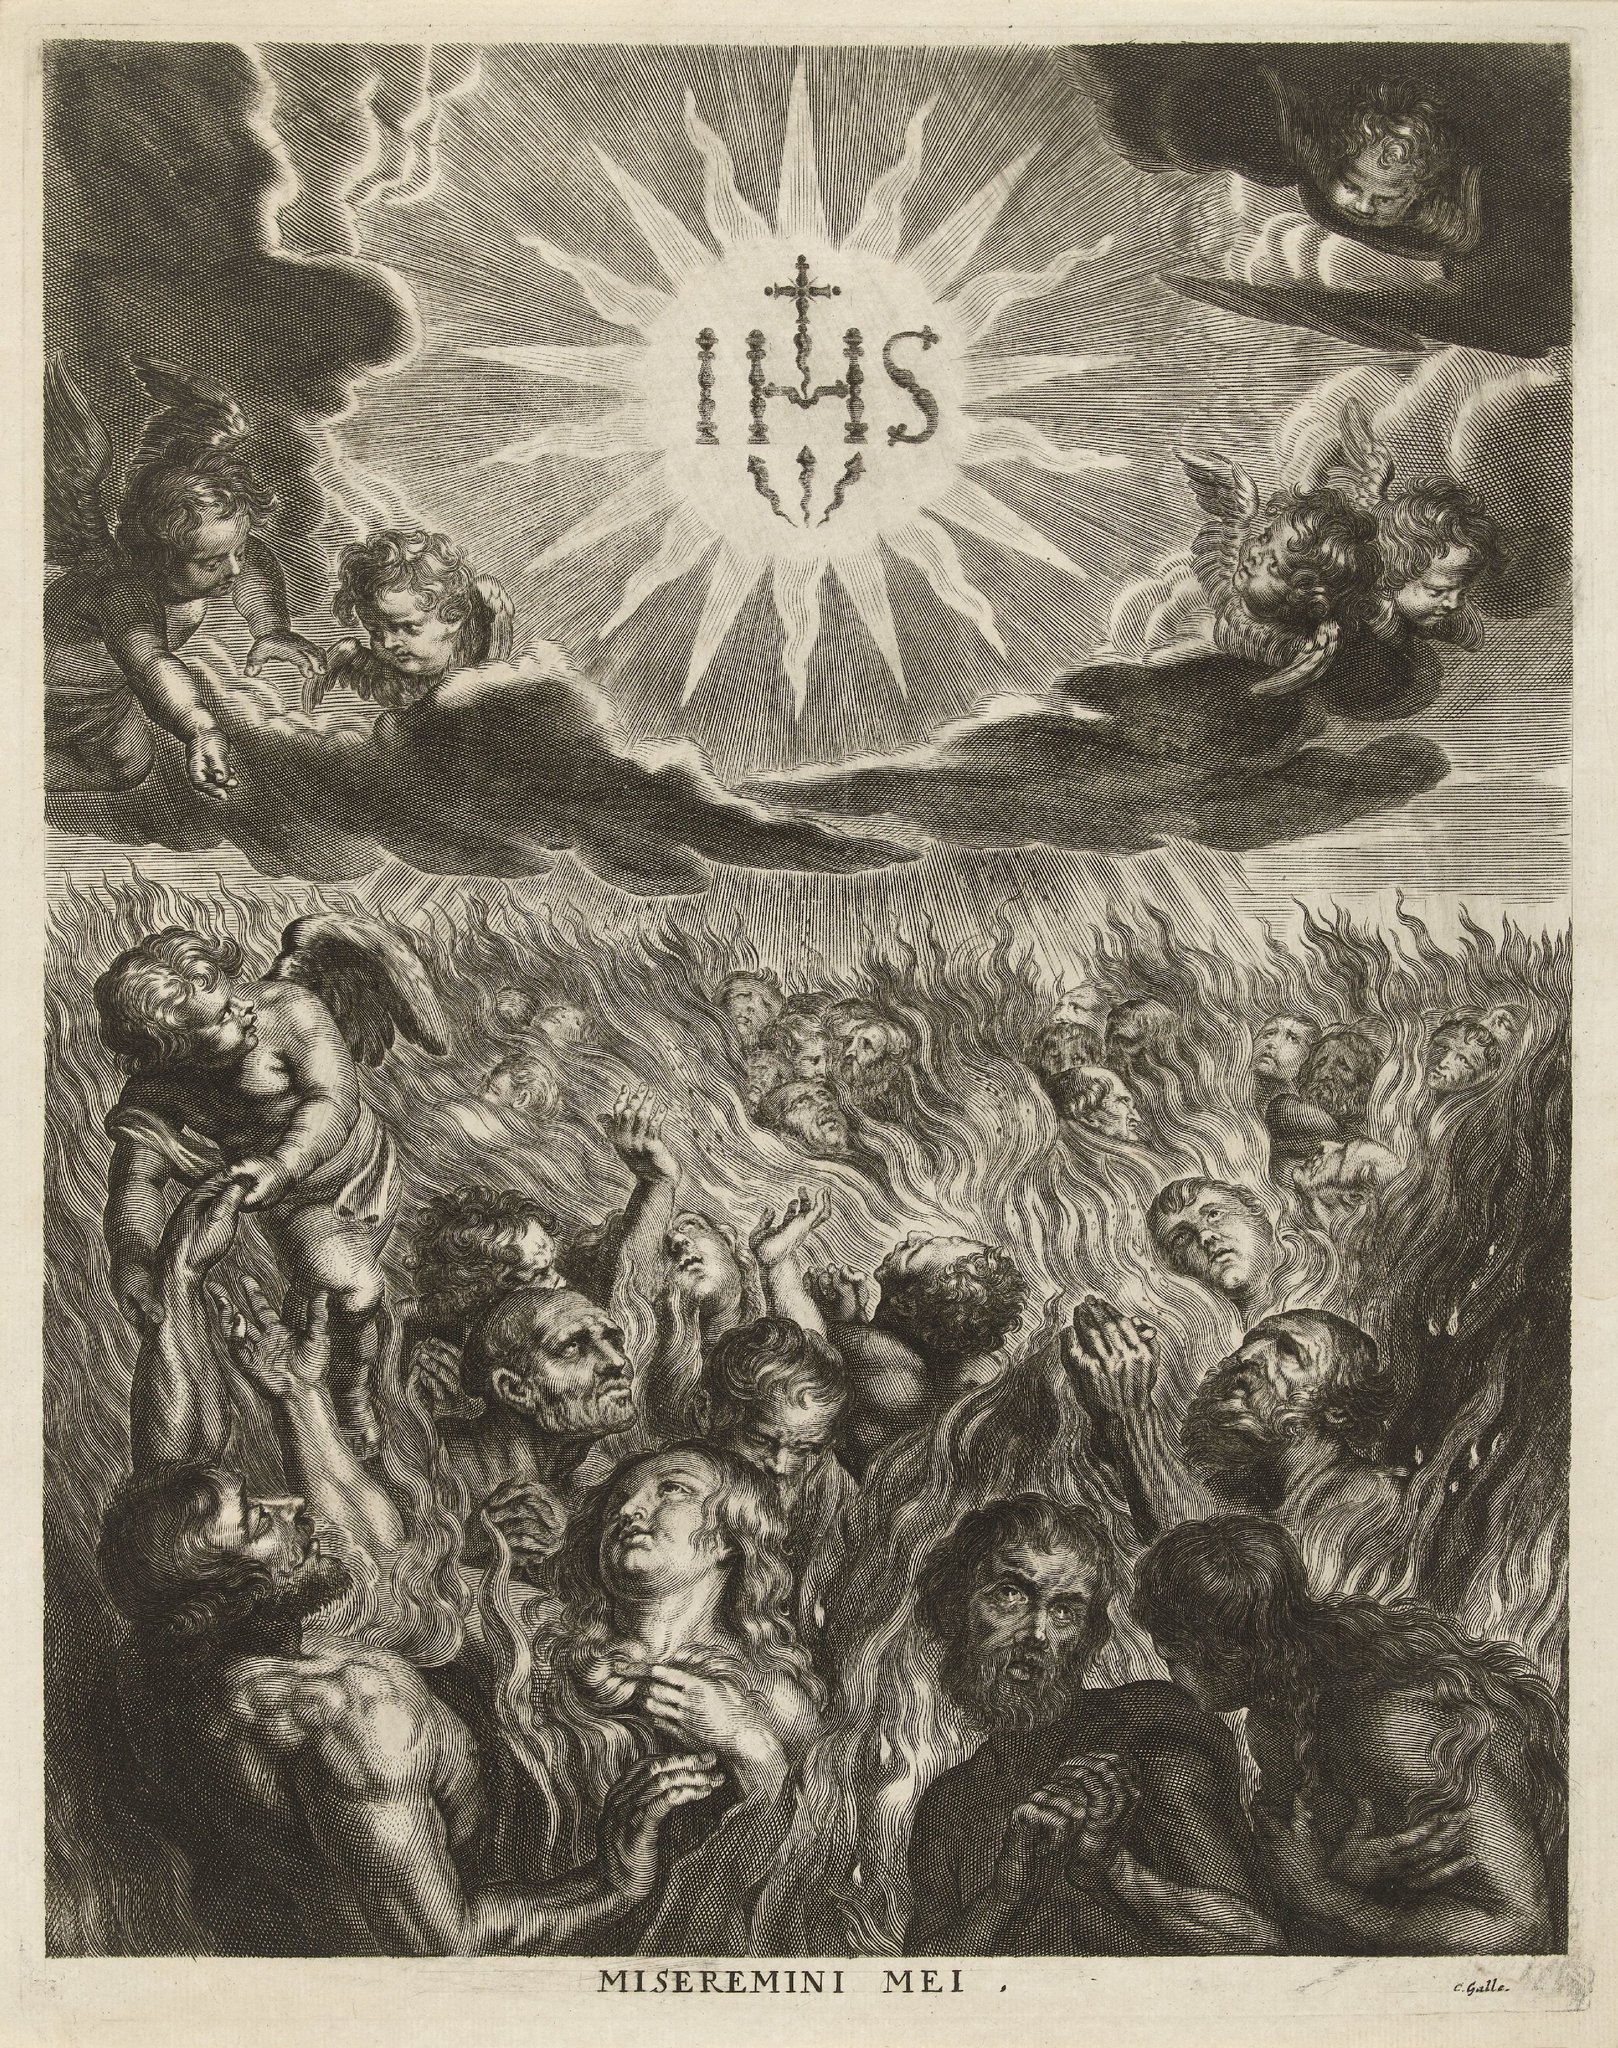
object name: print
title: Mensen in het vagevuur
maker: cornelis galle (i)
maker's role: print maker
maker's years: 1576-1650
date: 1610-1650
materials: paper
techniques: engraving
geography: southern netherlands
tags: ihs ('iesus hominum salvator') ~ symbol of christ, representations of hell (with the damned and devils), usually with burning fires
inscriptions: collector's mark: Lugt 240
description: Een grote groep mensen gaat op in de vlammenzee van het vagevuur. Een engel redt een van hen en trekt hem aan zijn arm uit het vuur omhoog naar de hemel. In de hemel kijken cherubijnen en engelen naar het vuur beneden. In het midden het Christusmonogram IHS in een stralende zon.